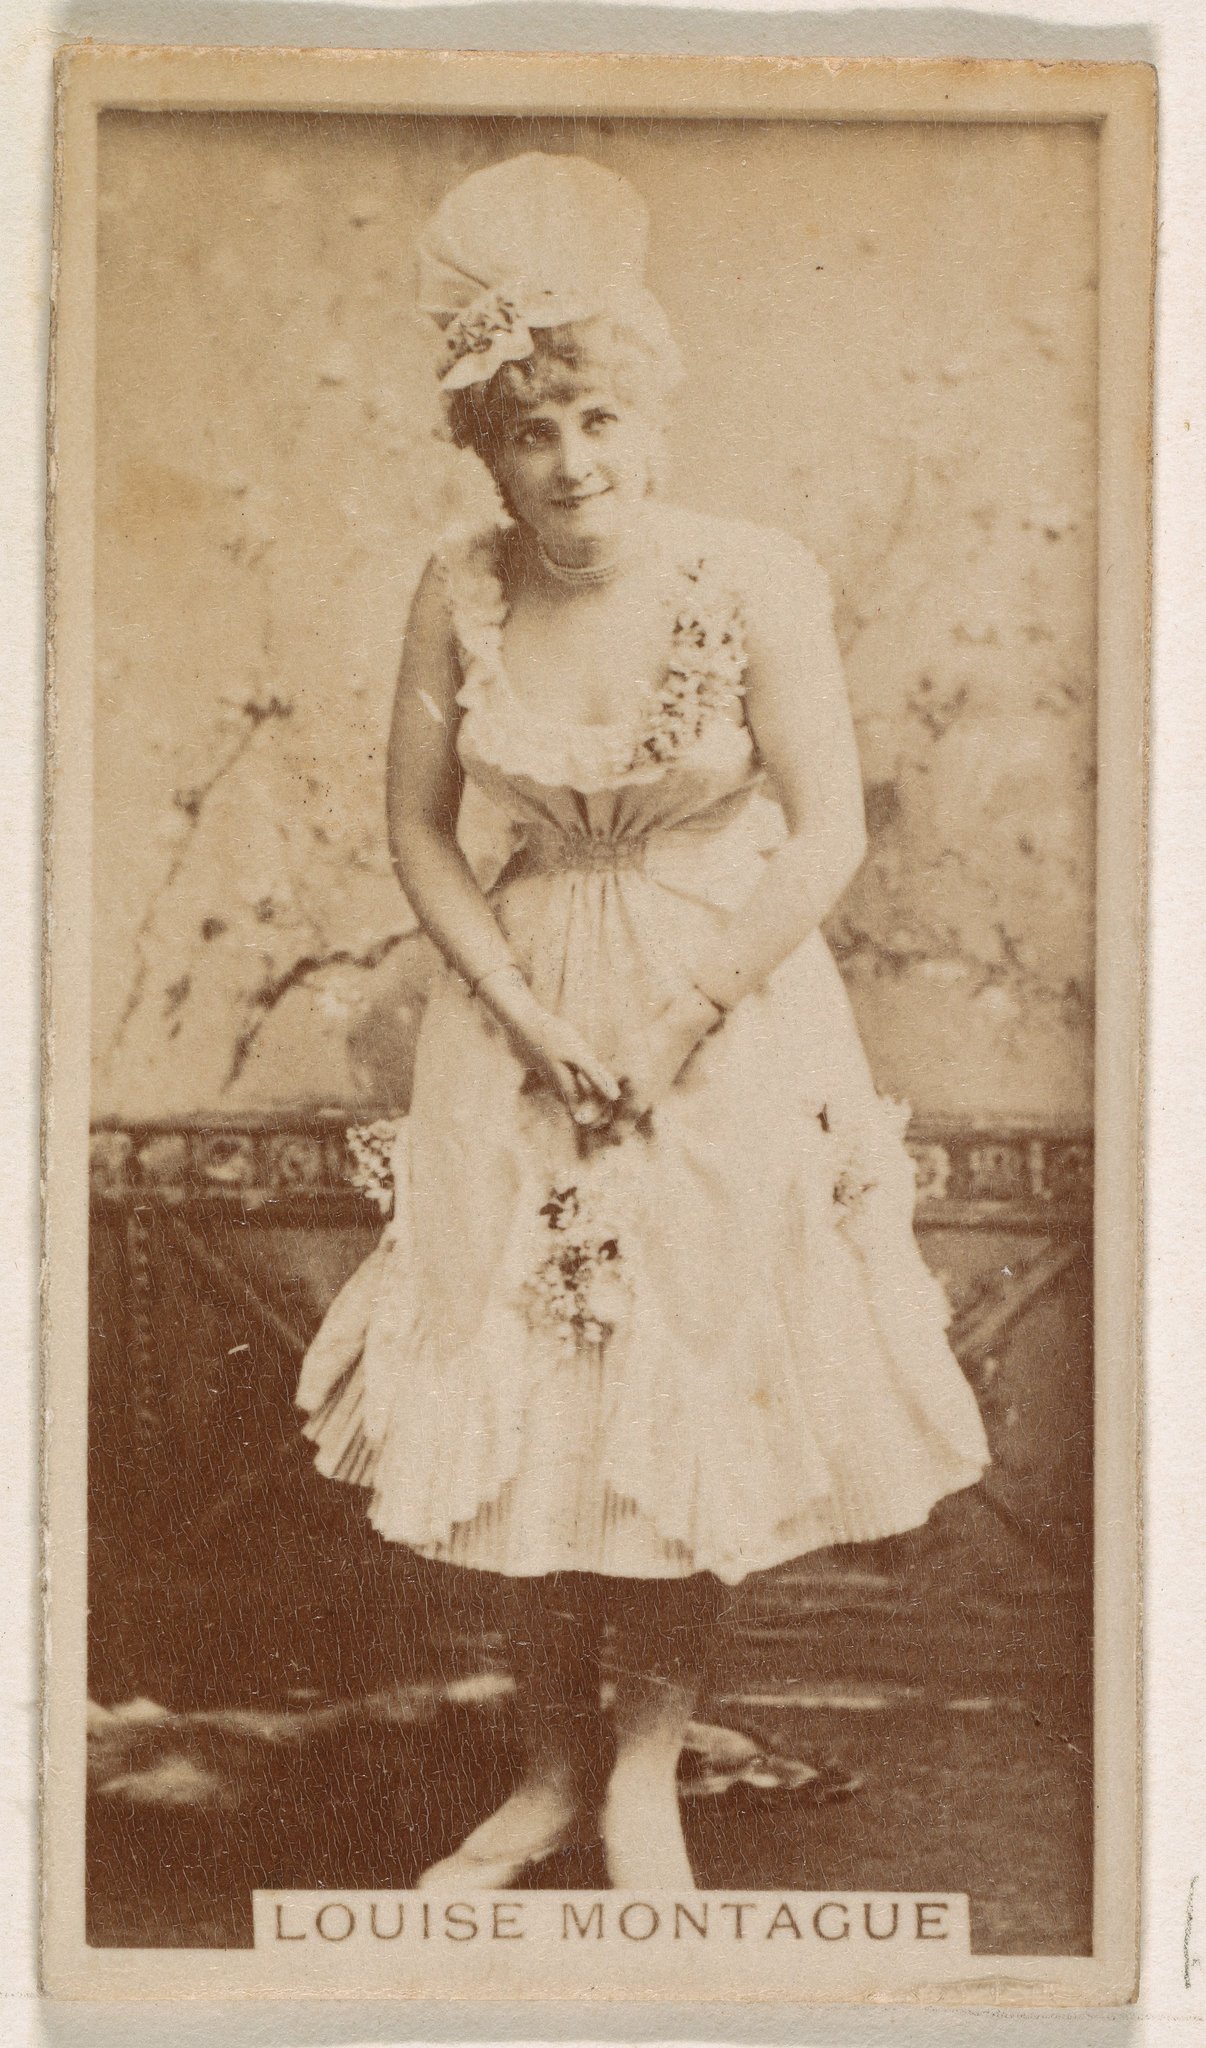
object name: photograph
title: Louise Montague, from the Actresses series (N245) issued by Kinney Brothers to promote Sweet Caporal Cigarettes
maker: kinney brothers tobacco company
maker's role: publisher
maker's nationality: american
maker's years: 1869-2011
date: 1890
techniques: albumen silver print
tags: portraits,women,actresses